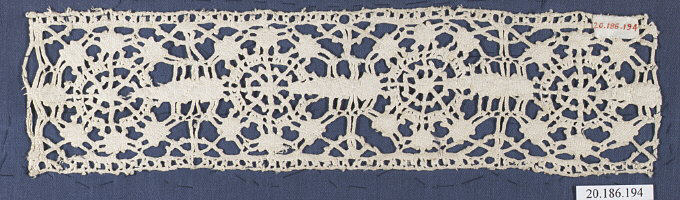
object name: insertion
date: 1601-1700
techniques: lace